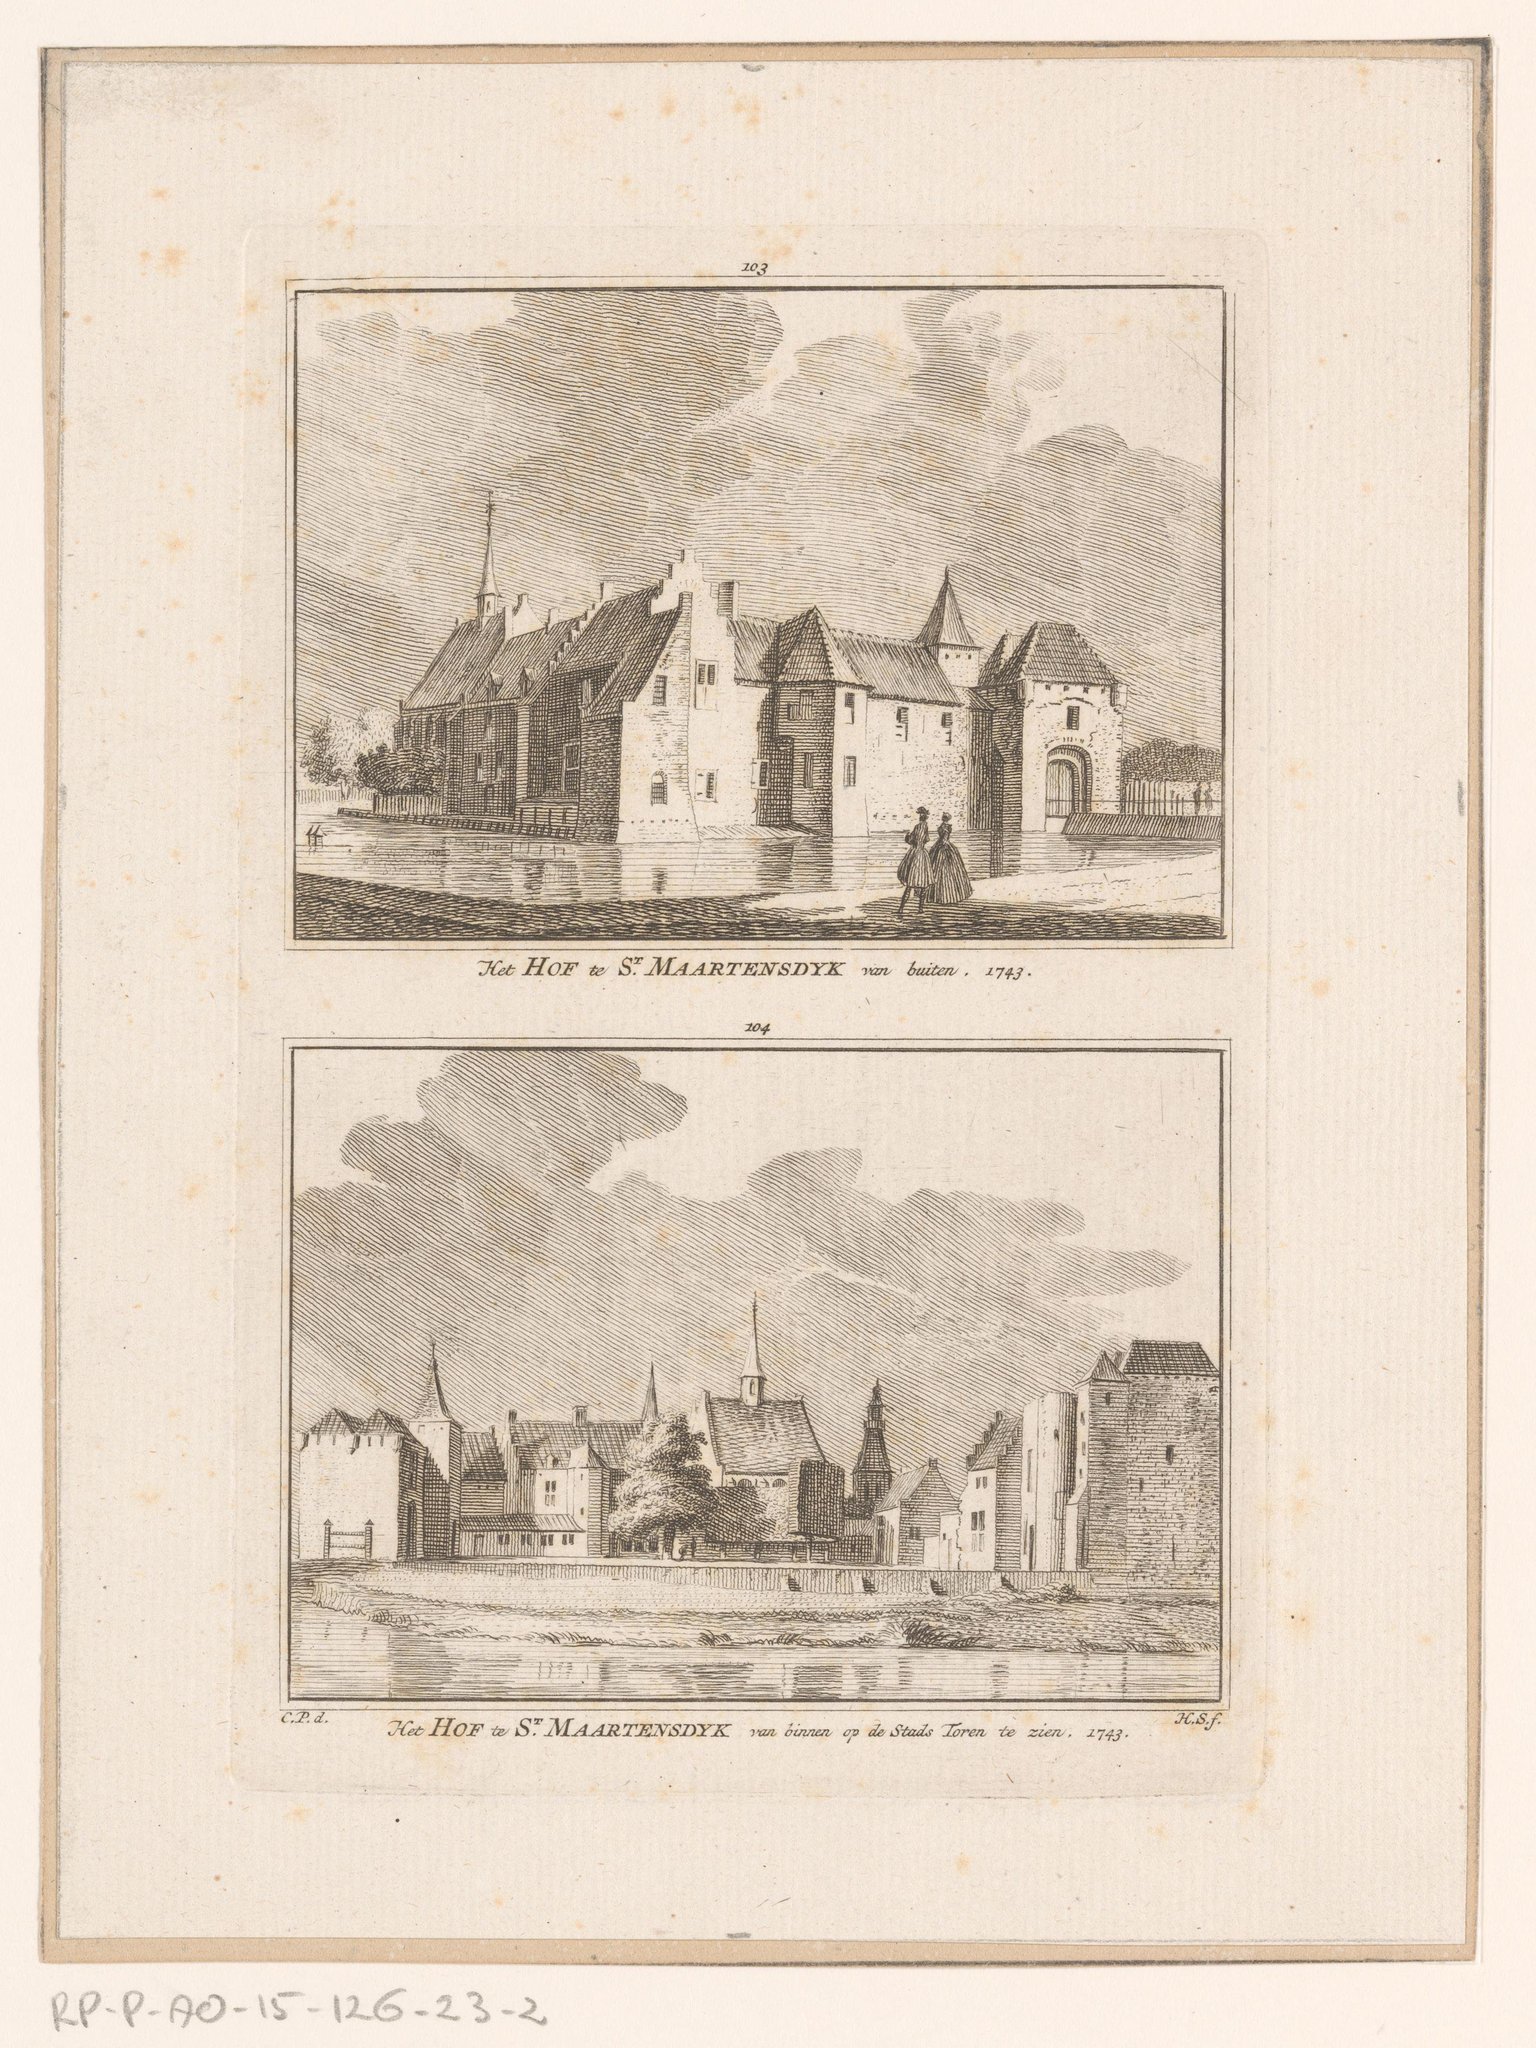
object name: book illustration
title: Het Hof te St. Maartensdyk van buiten. 1743 / Het Hof te St. Maartensdyk van binnen op de Stads Toren te zien. 1743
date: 1754-1792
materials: paper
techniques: etching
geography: haarlem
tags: castle, parts of church exterior and annexes: tower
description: Prent ook gebruikt in: Het verheerlykt Nederland of kabinet van hedendaagsche gezigten van steden, dorpen (…). 9 delen. Amsterdam: Isaak Tirion en weduwe Isaak Tirion, 1745-1774, dl. 5 (1754), ill. 103-104. Of in: Nederlandsche tafereelen; of eene keurige verzameling van negen honderd fraaije gezigten van steden, dorpen, sloten, oudheden [….]. 9 delen. Amsterdam: Jan de Groot, 1792, dl. 5, ill. 103-104.